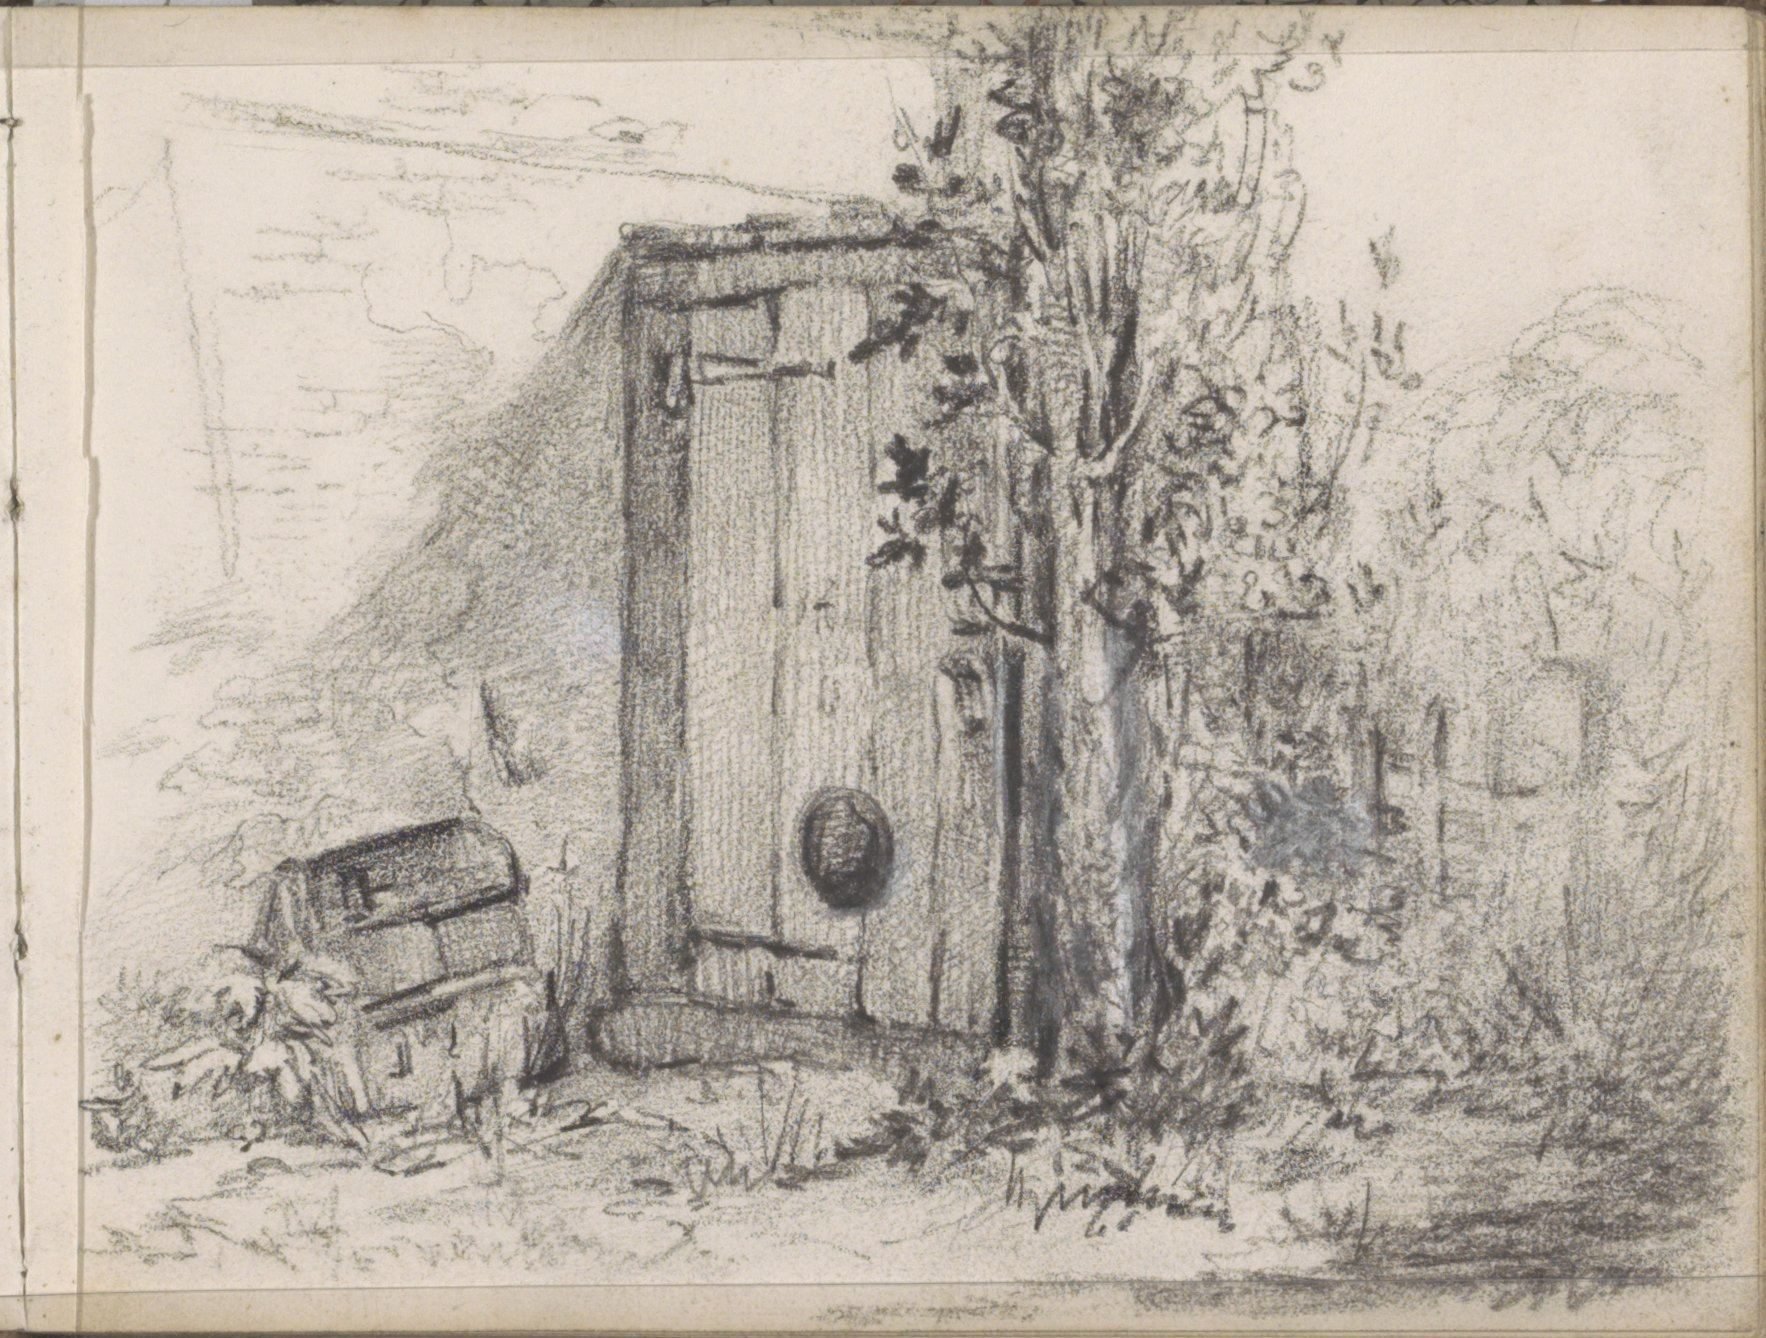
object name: sketchbook leaf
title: Houten schuurdeur in een tuin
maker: maria vos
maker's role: draughtsman, painter, print maker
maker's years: 1824-1906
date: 1834-1906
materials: chalk, paint, paper, pencil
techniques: brush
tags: garden, door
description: Blad 2 recto uit een schetsboek met 21 bladen.